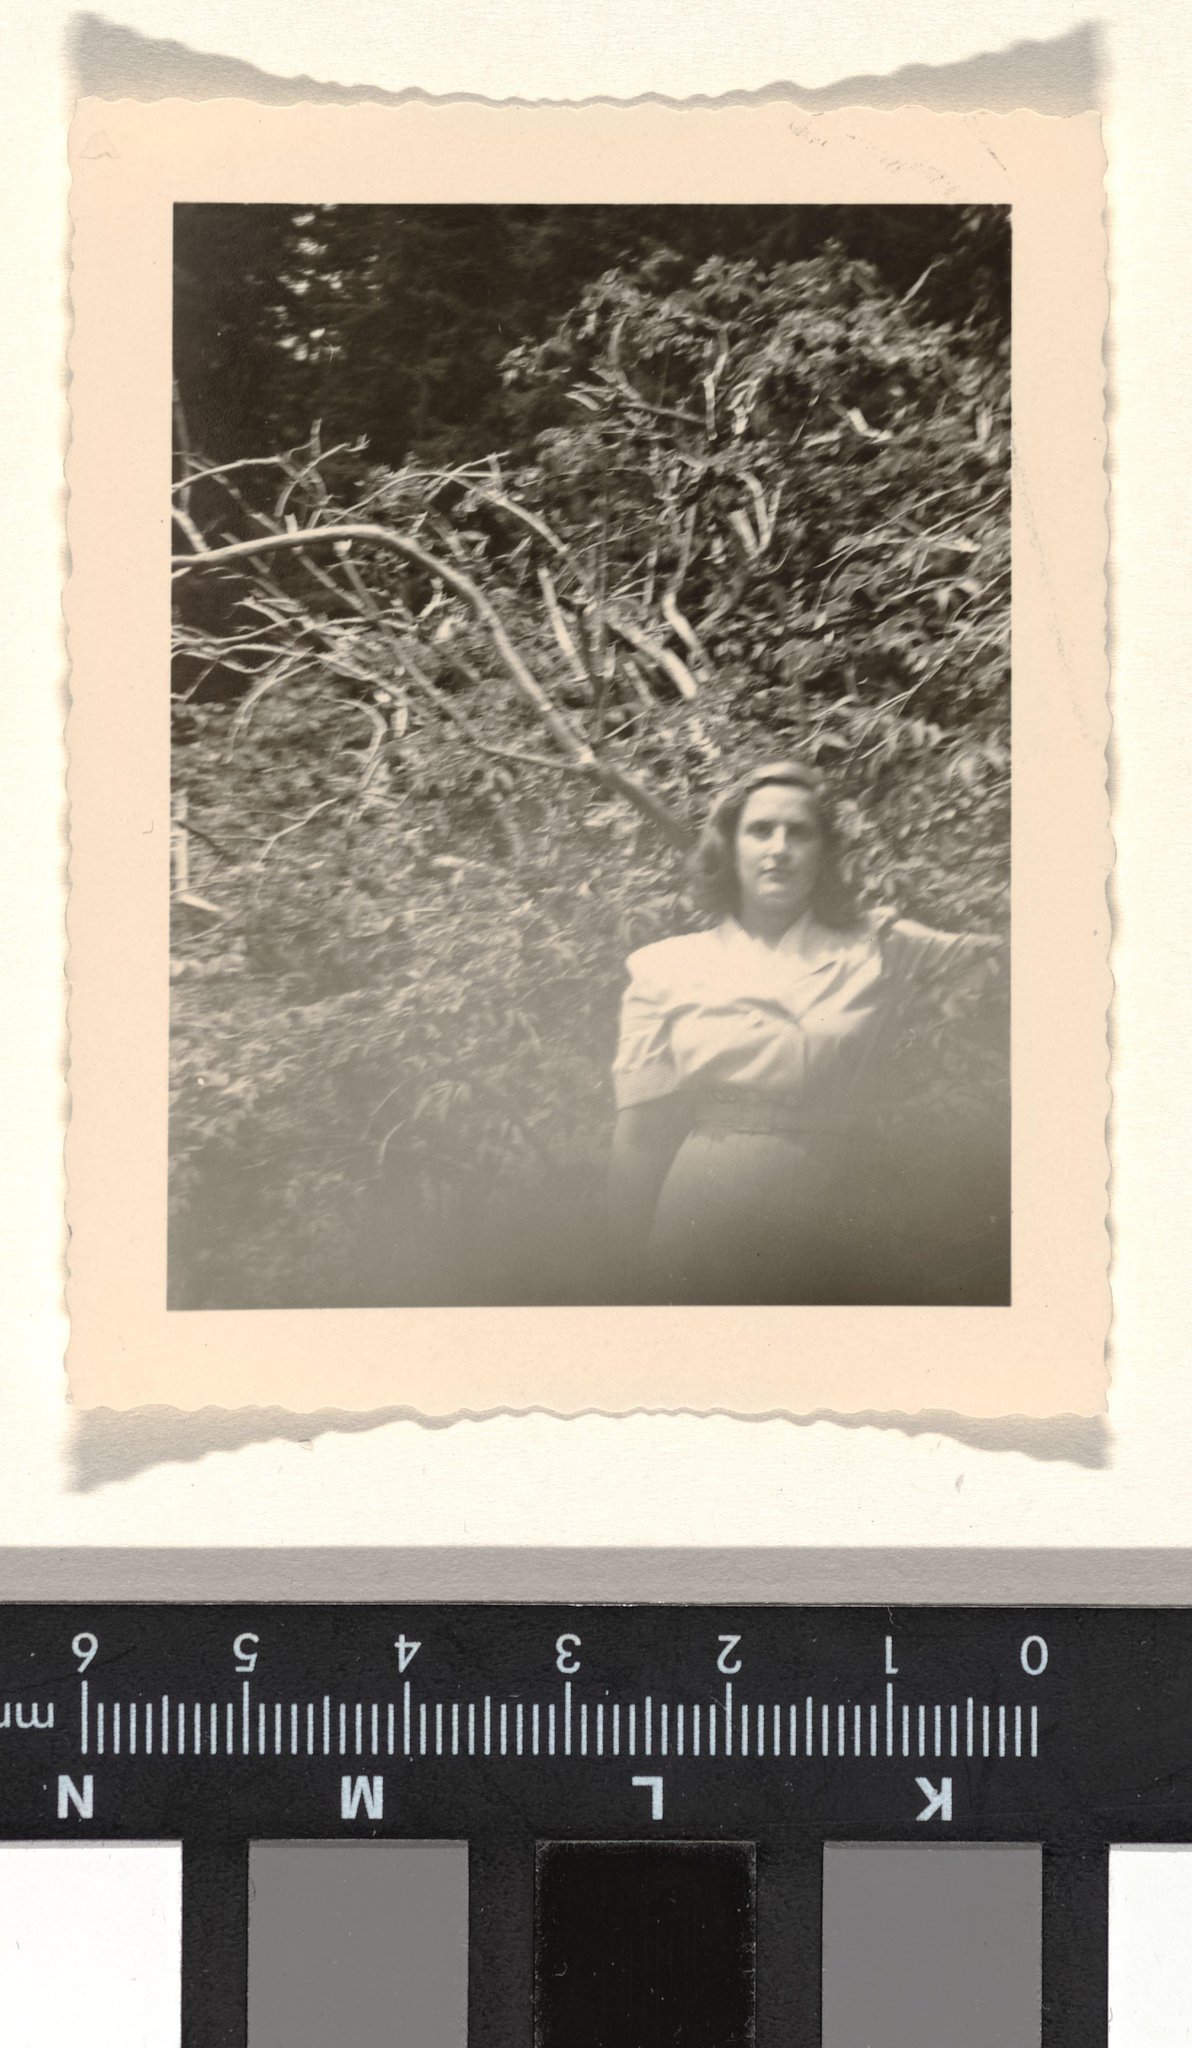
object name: photograph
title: Isabel Wachenheimer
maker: Anonymous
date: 1945-1958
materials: photographic support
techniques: gelatin silver print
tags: leiden, isabel wachenheimer-elon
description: Isabel Wachenheimer in licht hemd, staand voor een bosachtige omgeving. De onderkant van de foto is onscherp of bewogen.